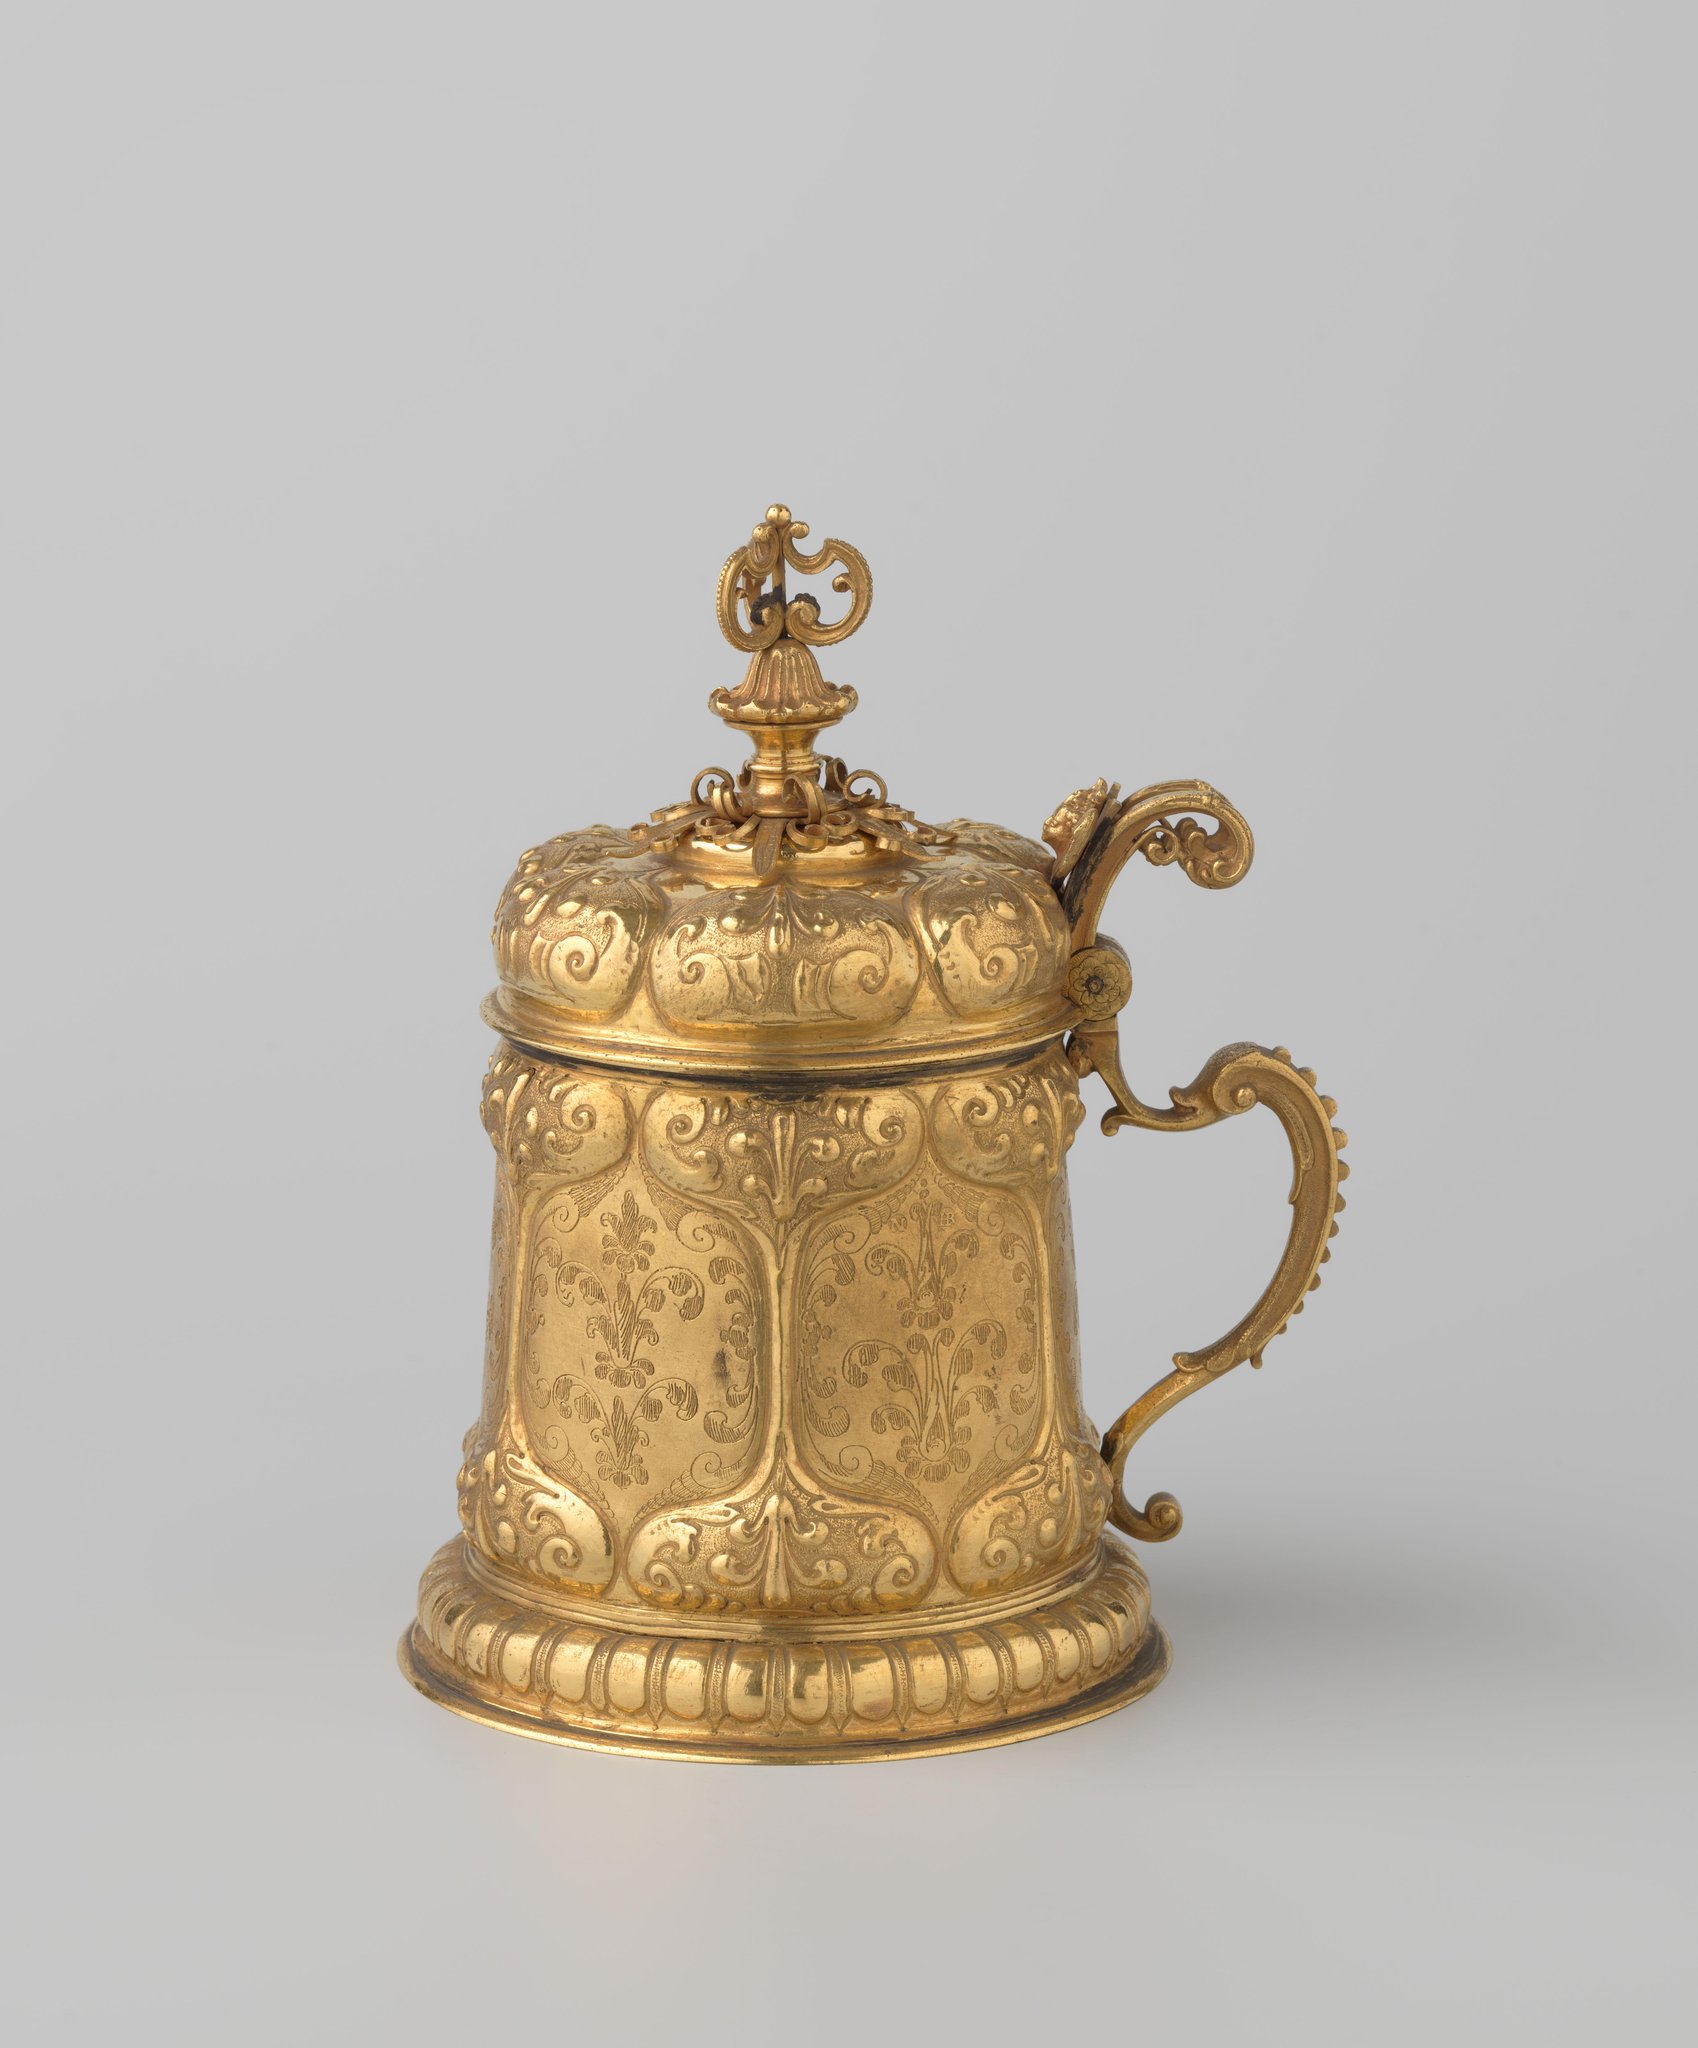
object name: stave tankard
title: Galvanoplastische reproductie van een drinkkan met rol- en bladwerk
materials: copper, silver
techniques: gilding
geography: london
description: Galvanoplastische reproductie van een drinkkan gedreven, gehamerd en gegraveerd met rol- en bladwerk. Verguld.